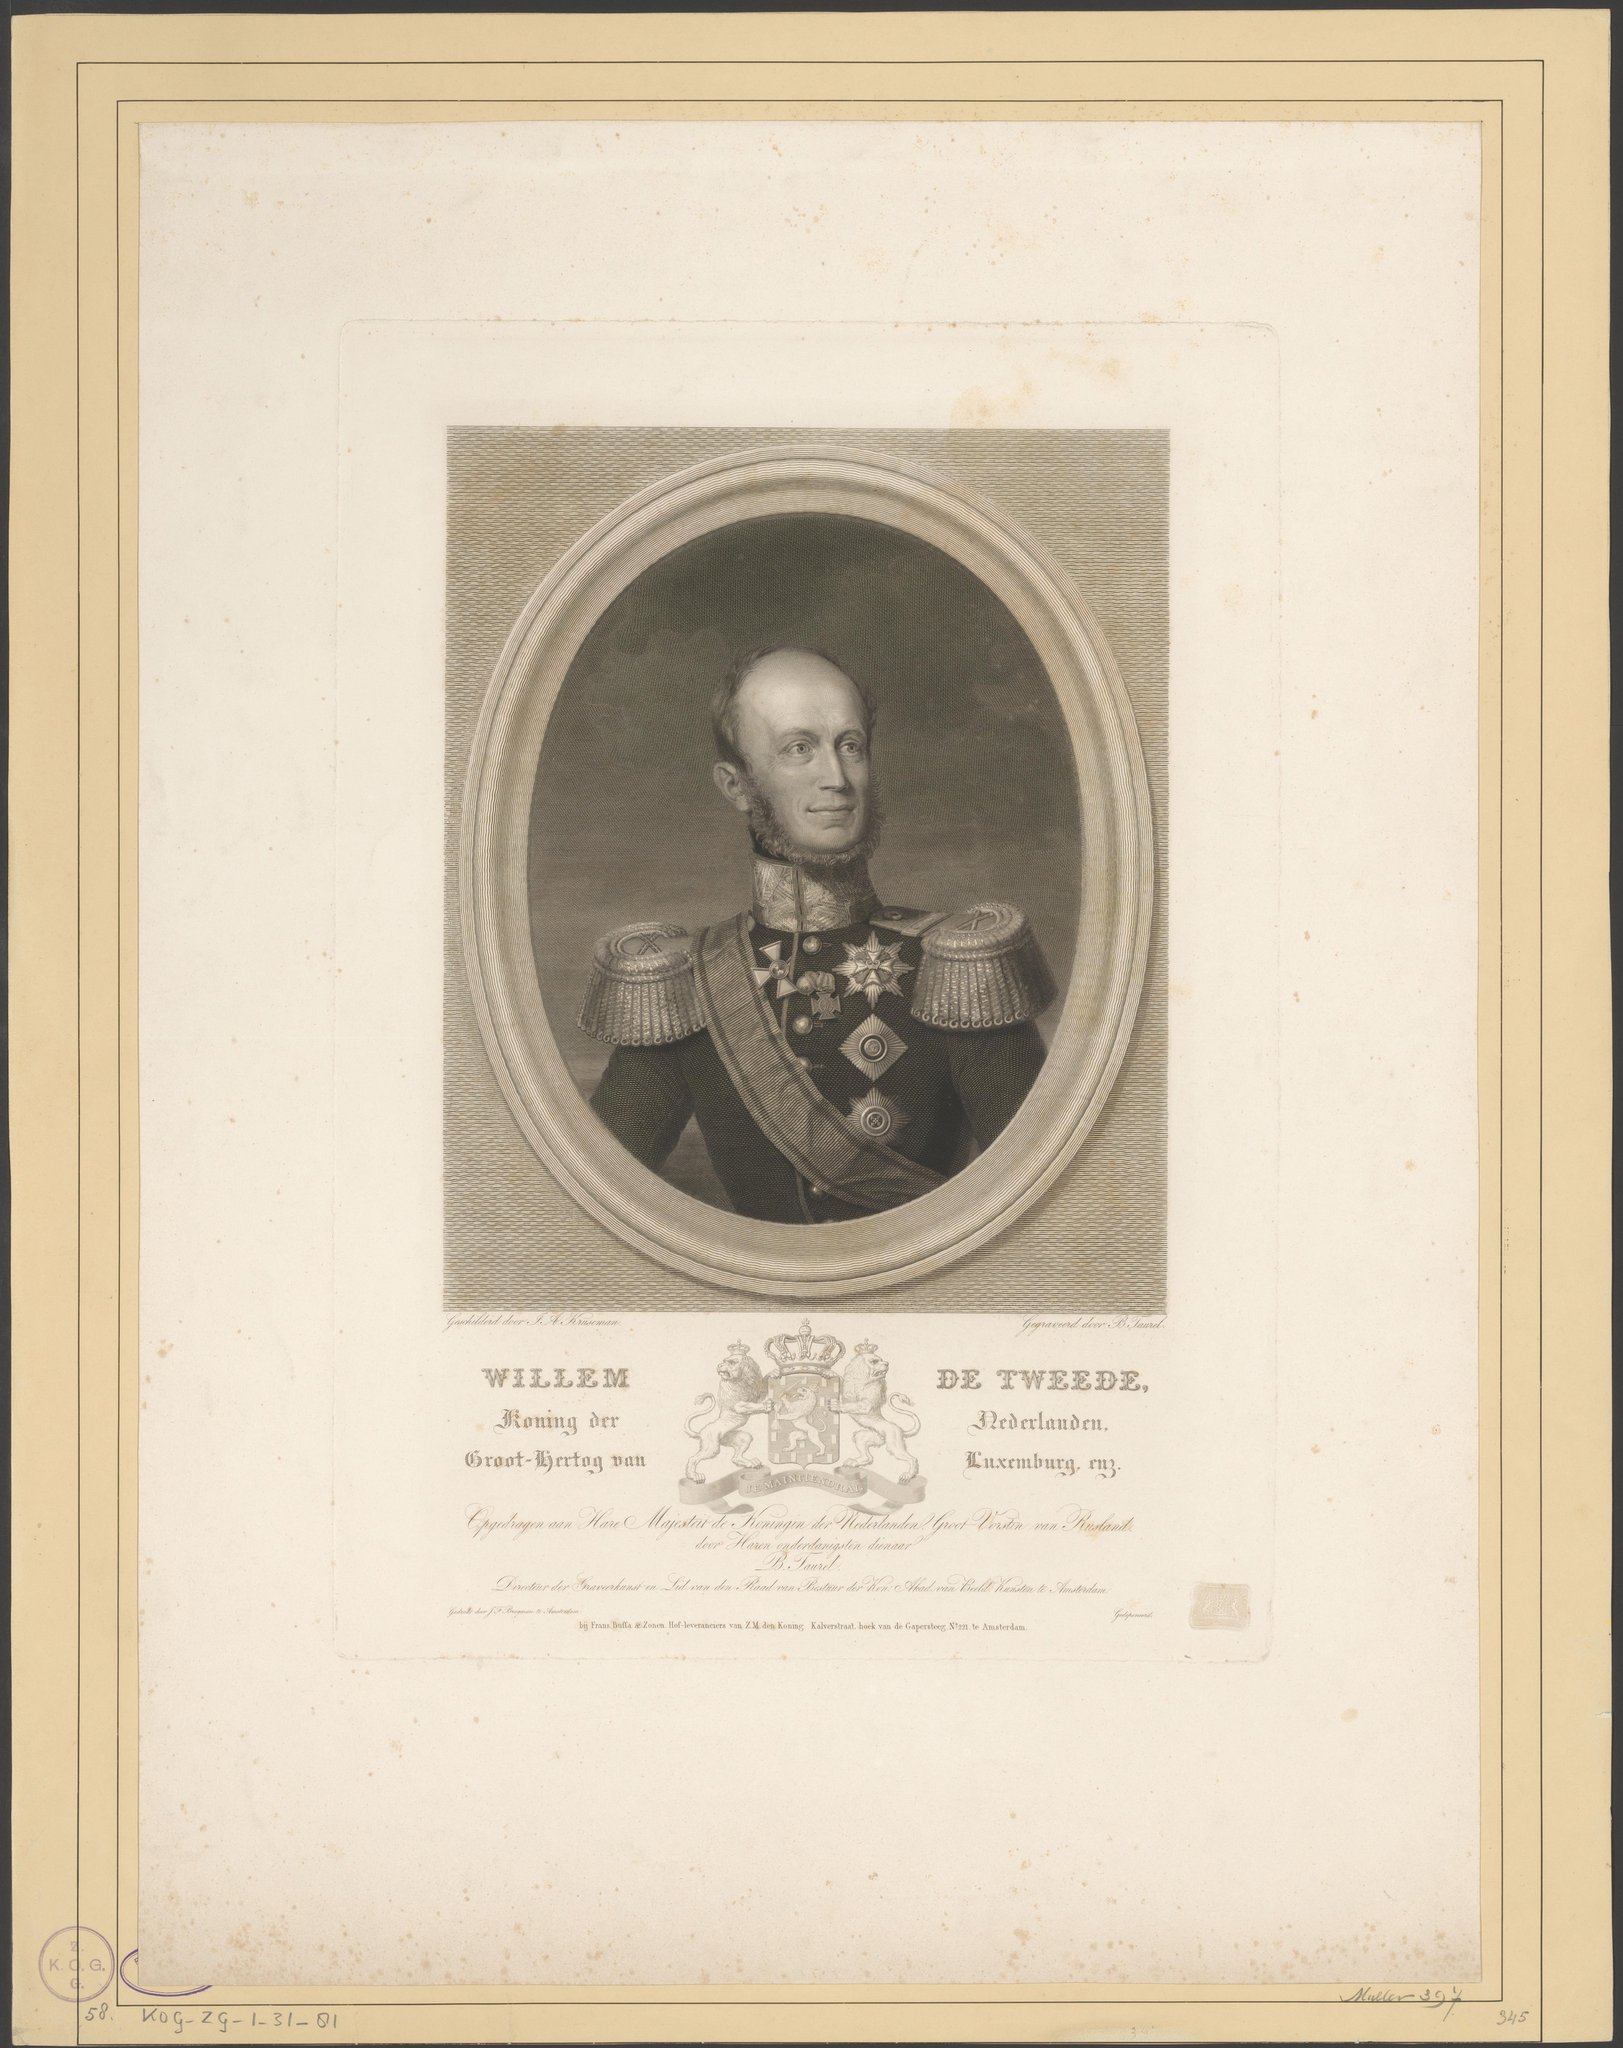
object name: print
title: Willem de Tweede, Koning der Nederlanden, Groot-Hertog van Luzemburg. enz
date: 1845-1898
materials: paper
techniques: engraving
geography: amsterdam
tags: the hague, william ii of the netherlands, historical persons, king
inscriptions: stamp, collector's mark: Lugt 1641, check stamp: ‘François Buffa & Fils’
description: Onderaan een wapenschild met twee staande leeuwen. Onderwerpsrubrieken binnen de Atlas Zeden en Gewoonten: Portretten, Portretten van Vorsten uit het huis van Oranje, Regeerende Vorsten, Koningen uit het huis van Oranje.